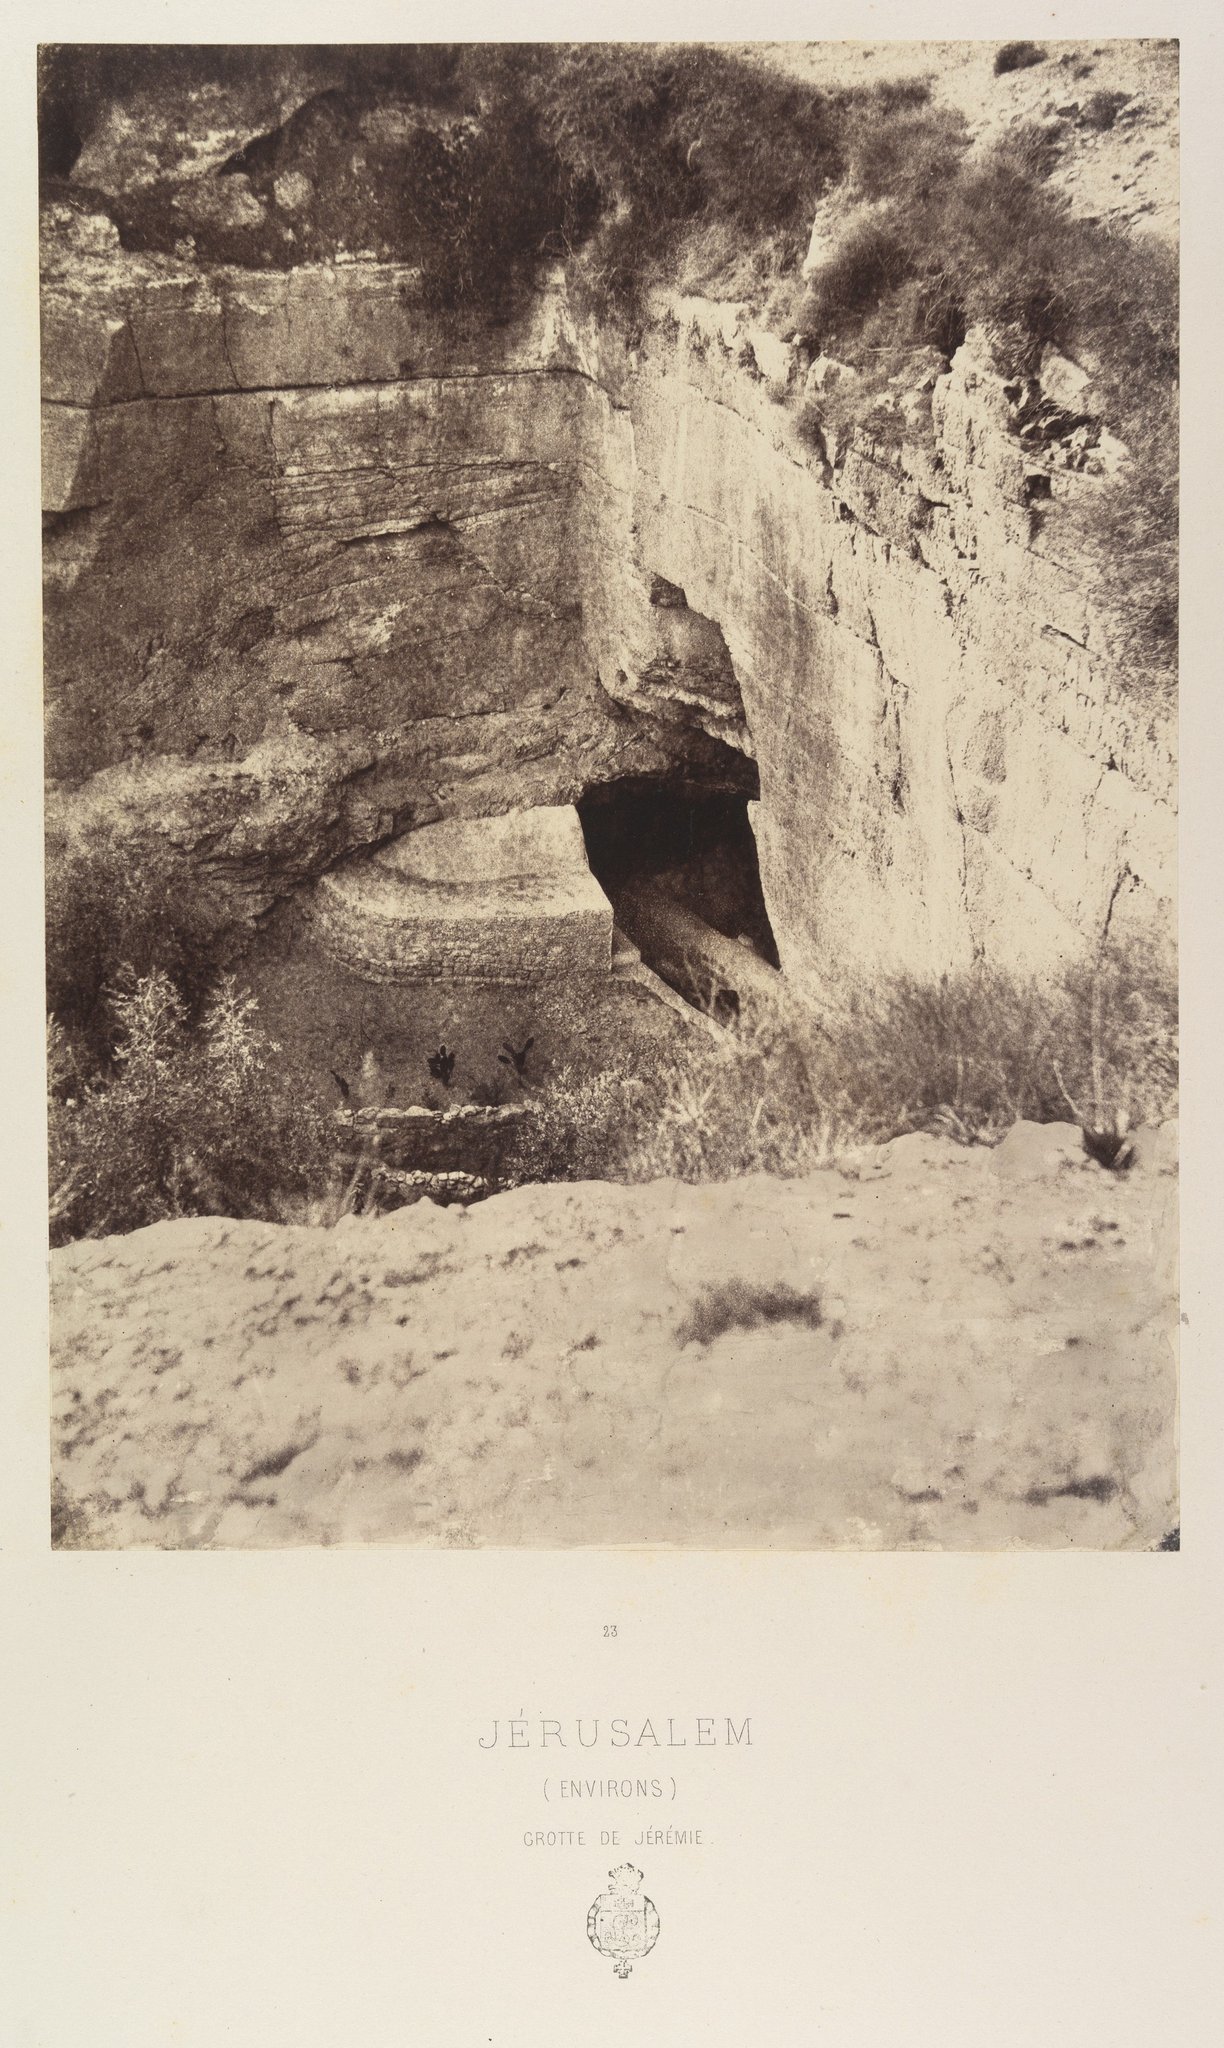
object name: photograph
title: Jérusalem. (Environs) Grotte de Jérémie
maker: louis de clercq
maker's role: artist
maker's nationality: french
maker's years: 1837-1901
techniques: albumen silver print, paper negative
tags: landscapes